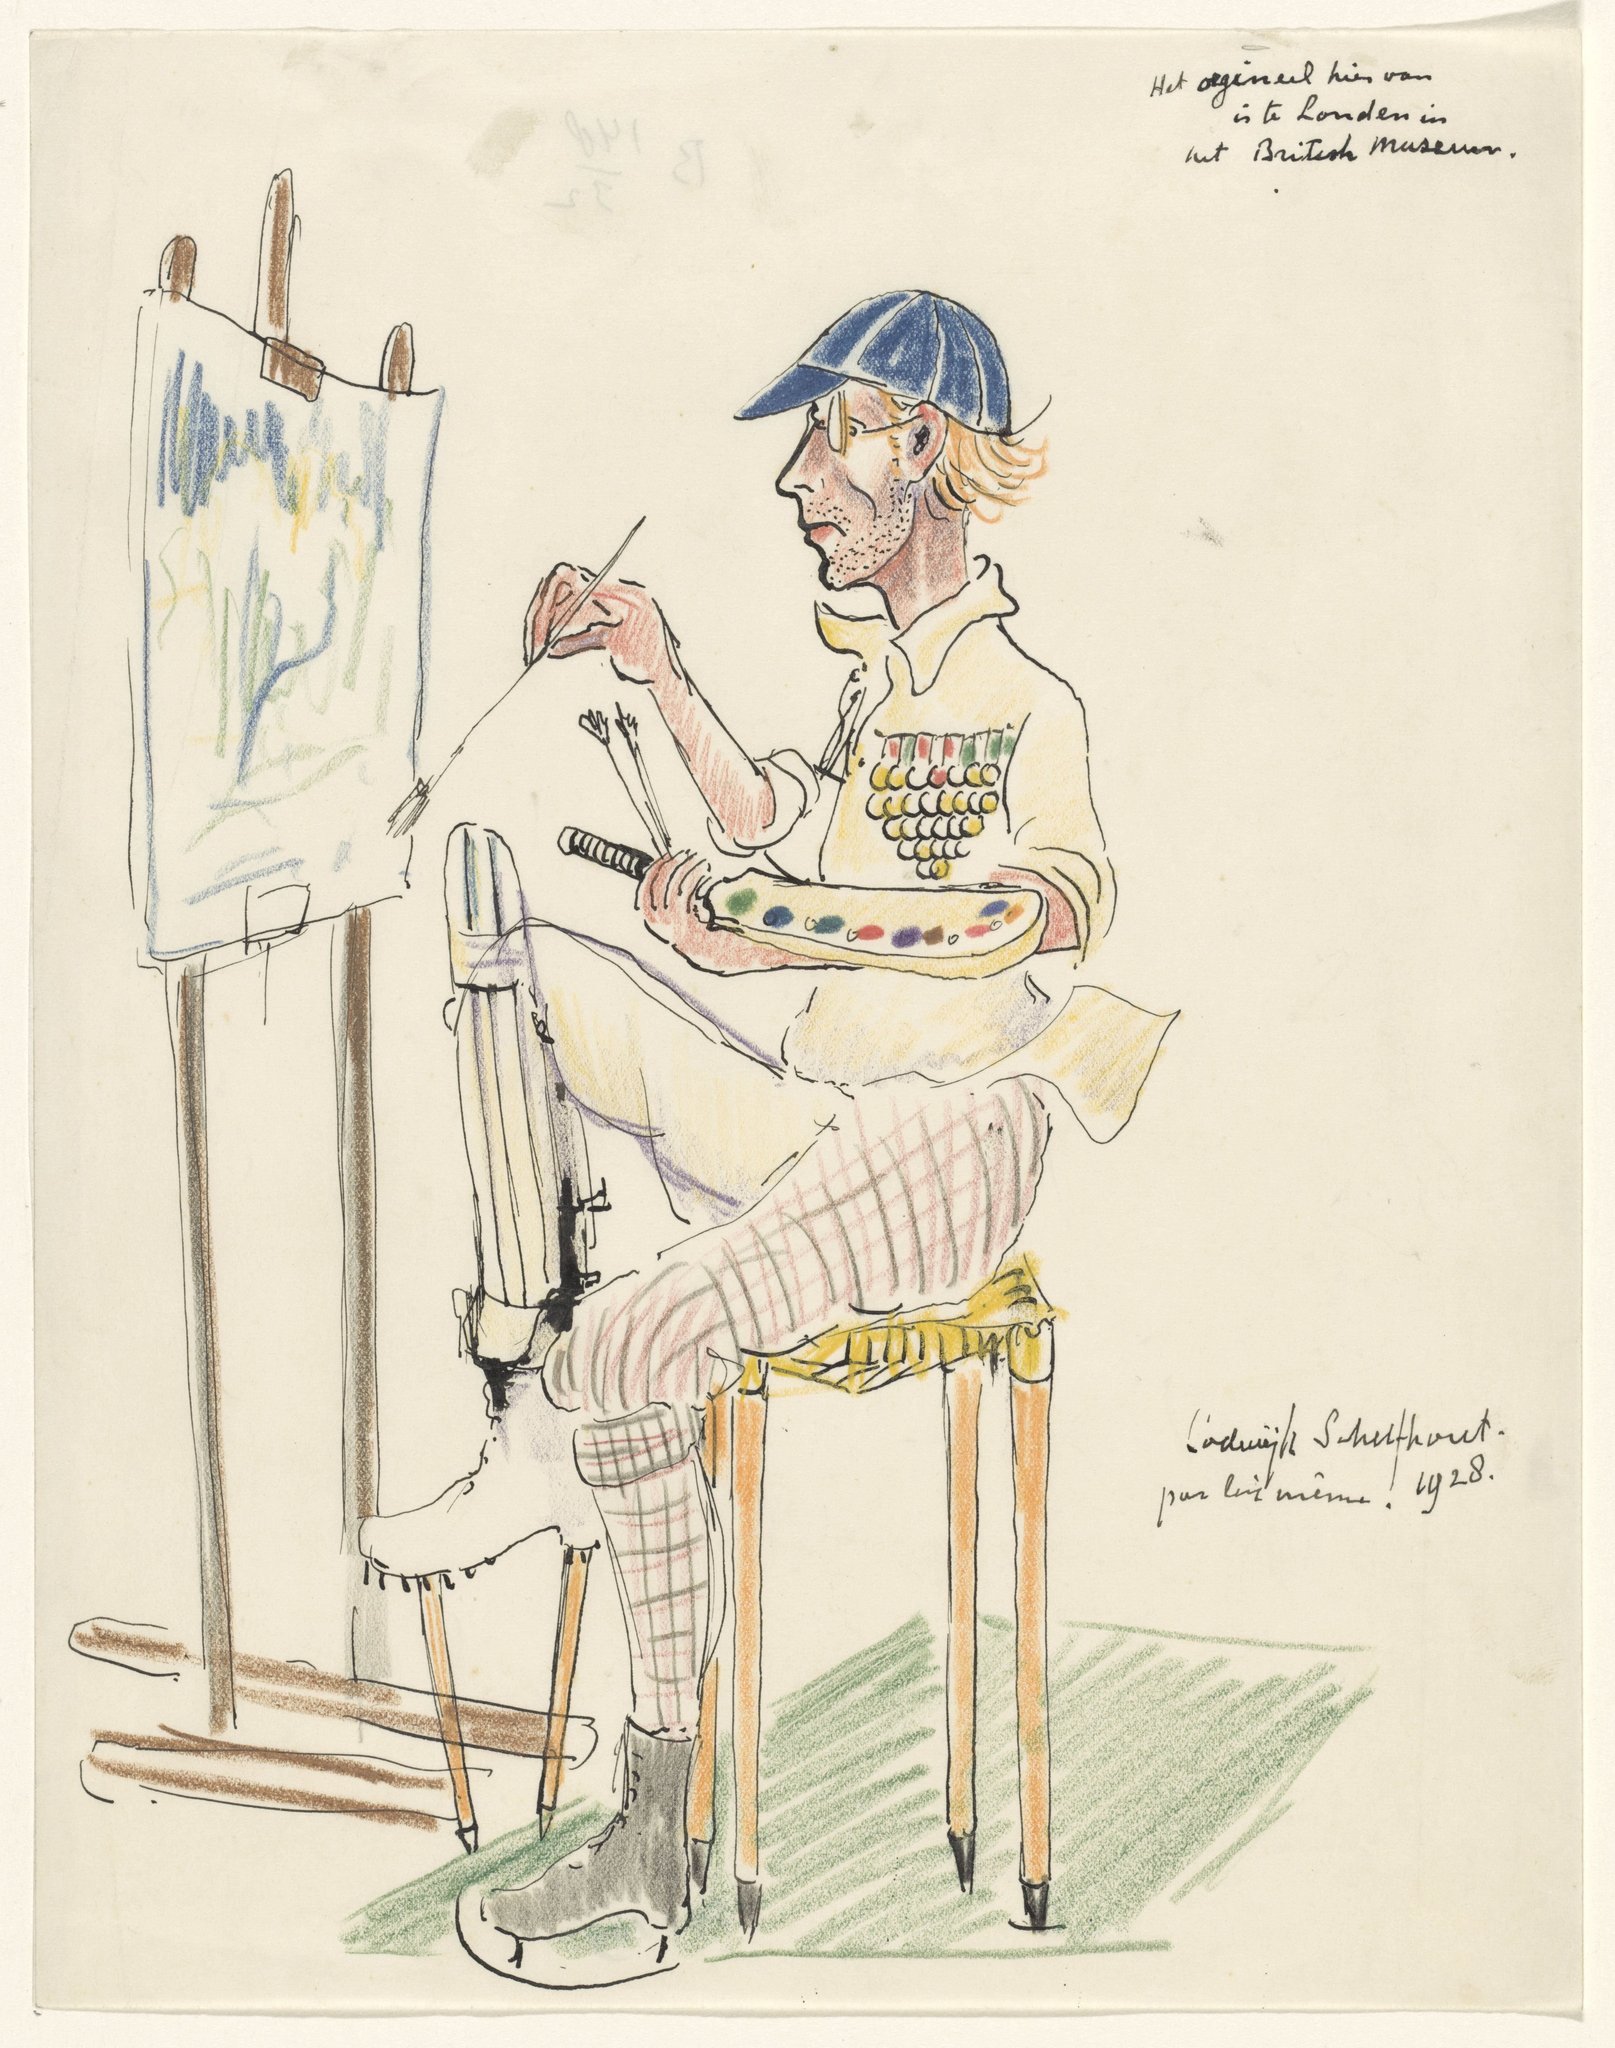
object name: drawing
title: Karikaturaal zelfportret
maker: lodewijk schelfhout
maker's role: draughtsman, print maker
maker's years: 1881-1943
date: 1928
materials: ink, paper, pencil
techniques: pen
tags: the hague, draughtsman, lodewijk schelfhout, caricatures (human types), historical persons, portrait, self-portrait of artist